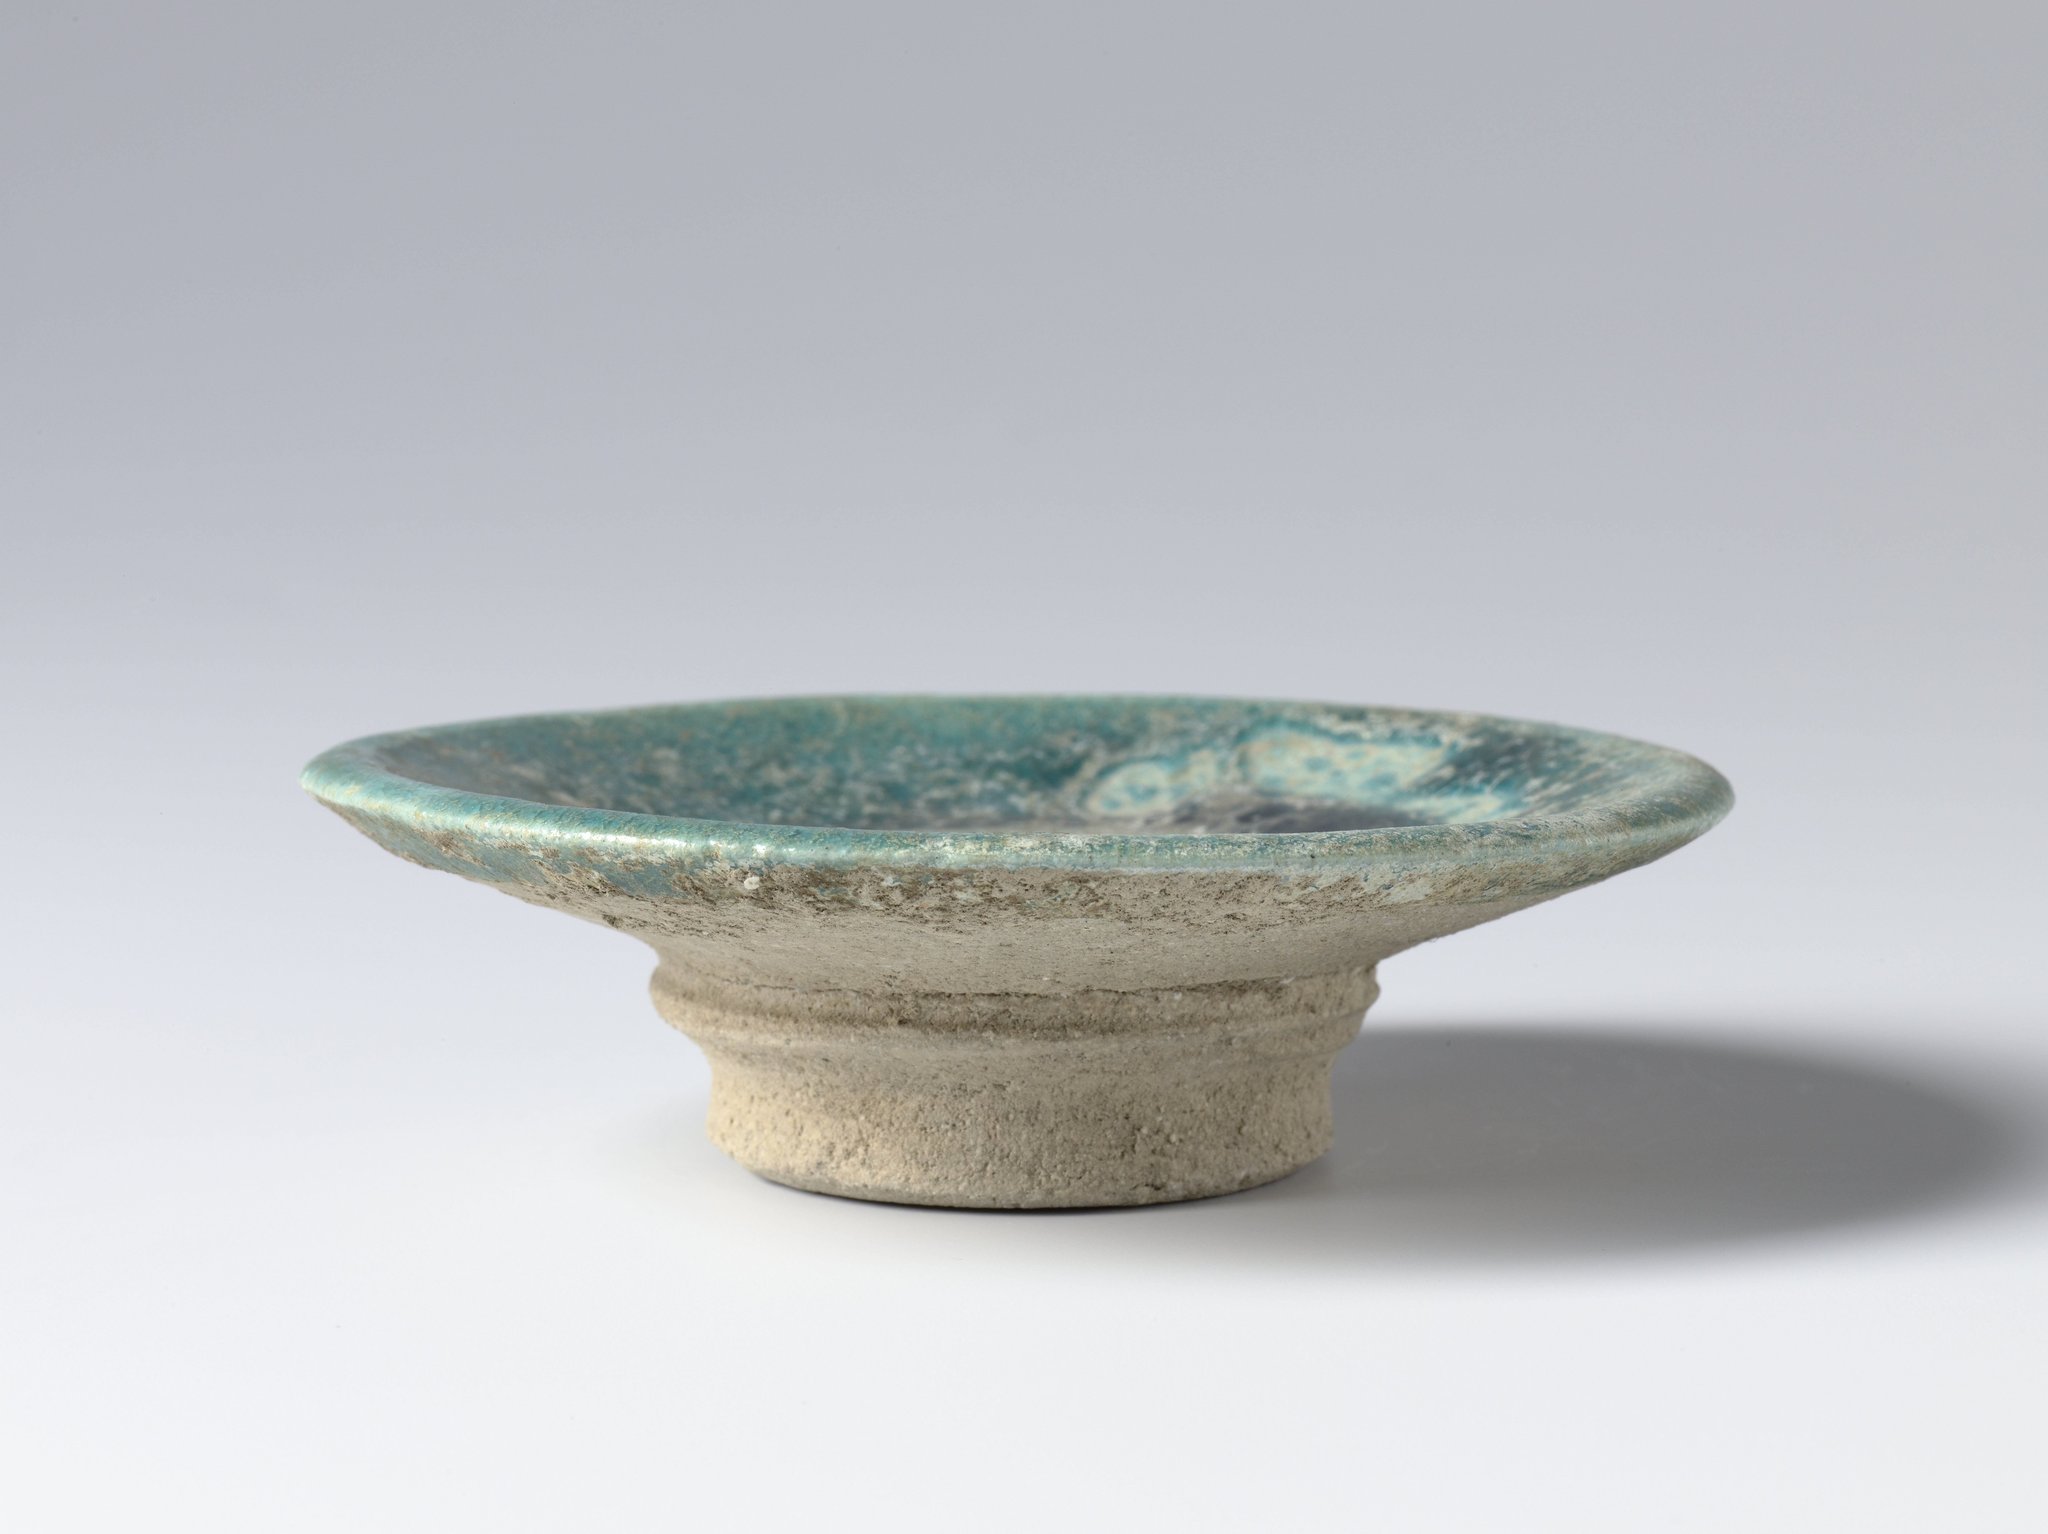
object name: bowl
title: Shallow bowl on foot with a turquoise glaze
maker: Anonymous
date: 1175-1224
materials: earthenware, glaze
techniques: firing, turning, vitrification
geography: afghanistan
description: Lage kom op voet van aardewerk bedekt met een monochroom turquoise loodglazuur.